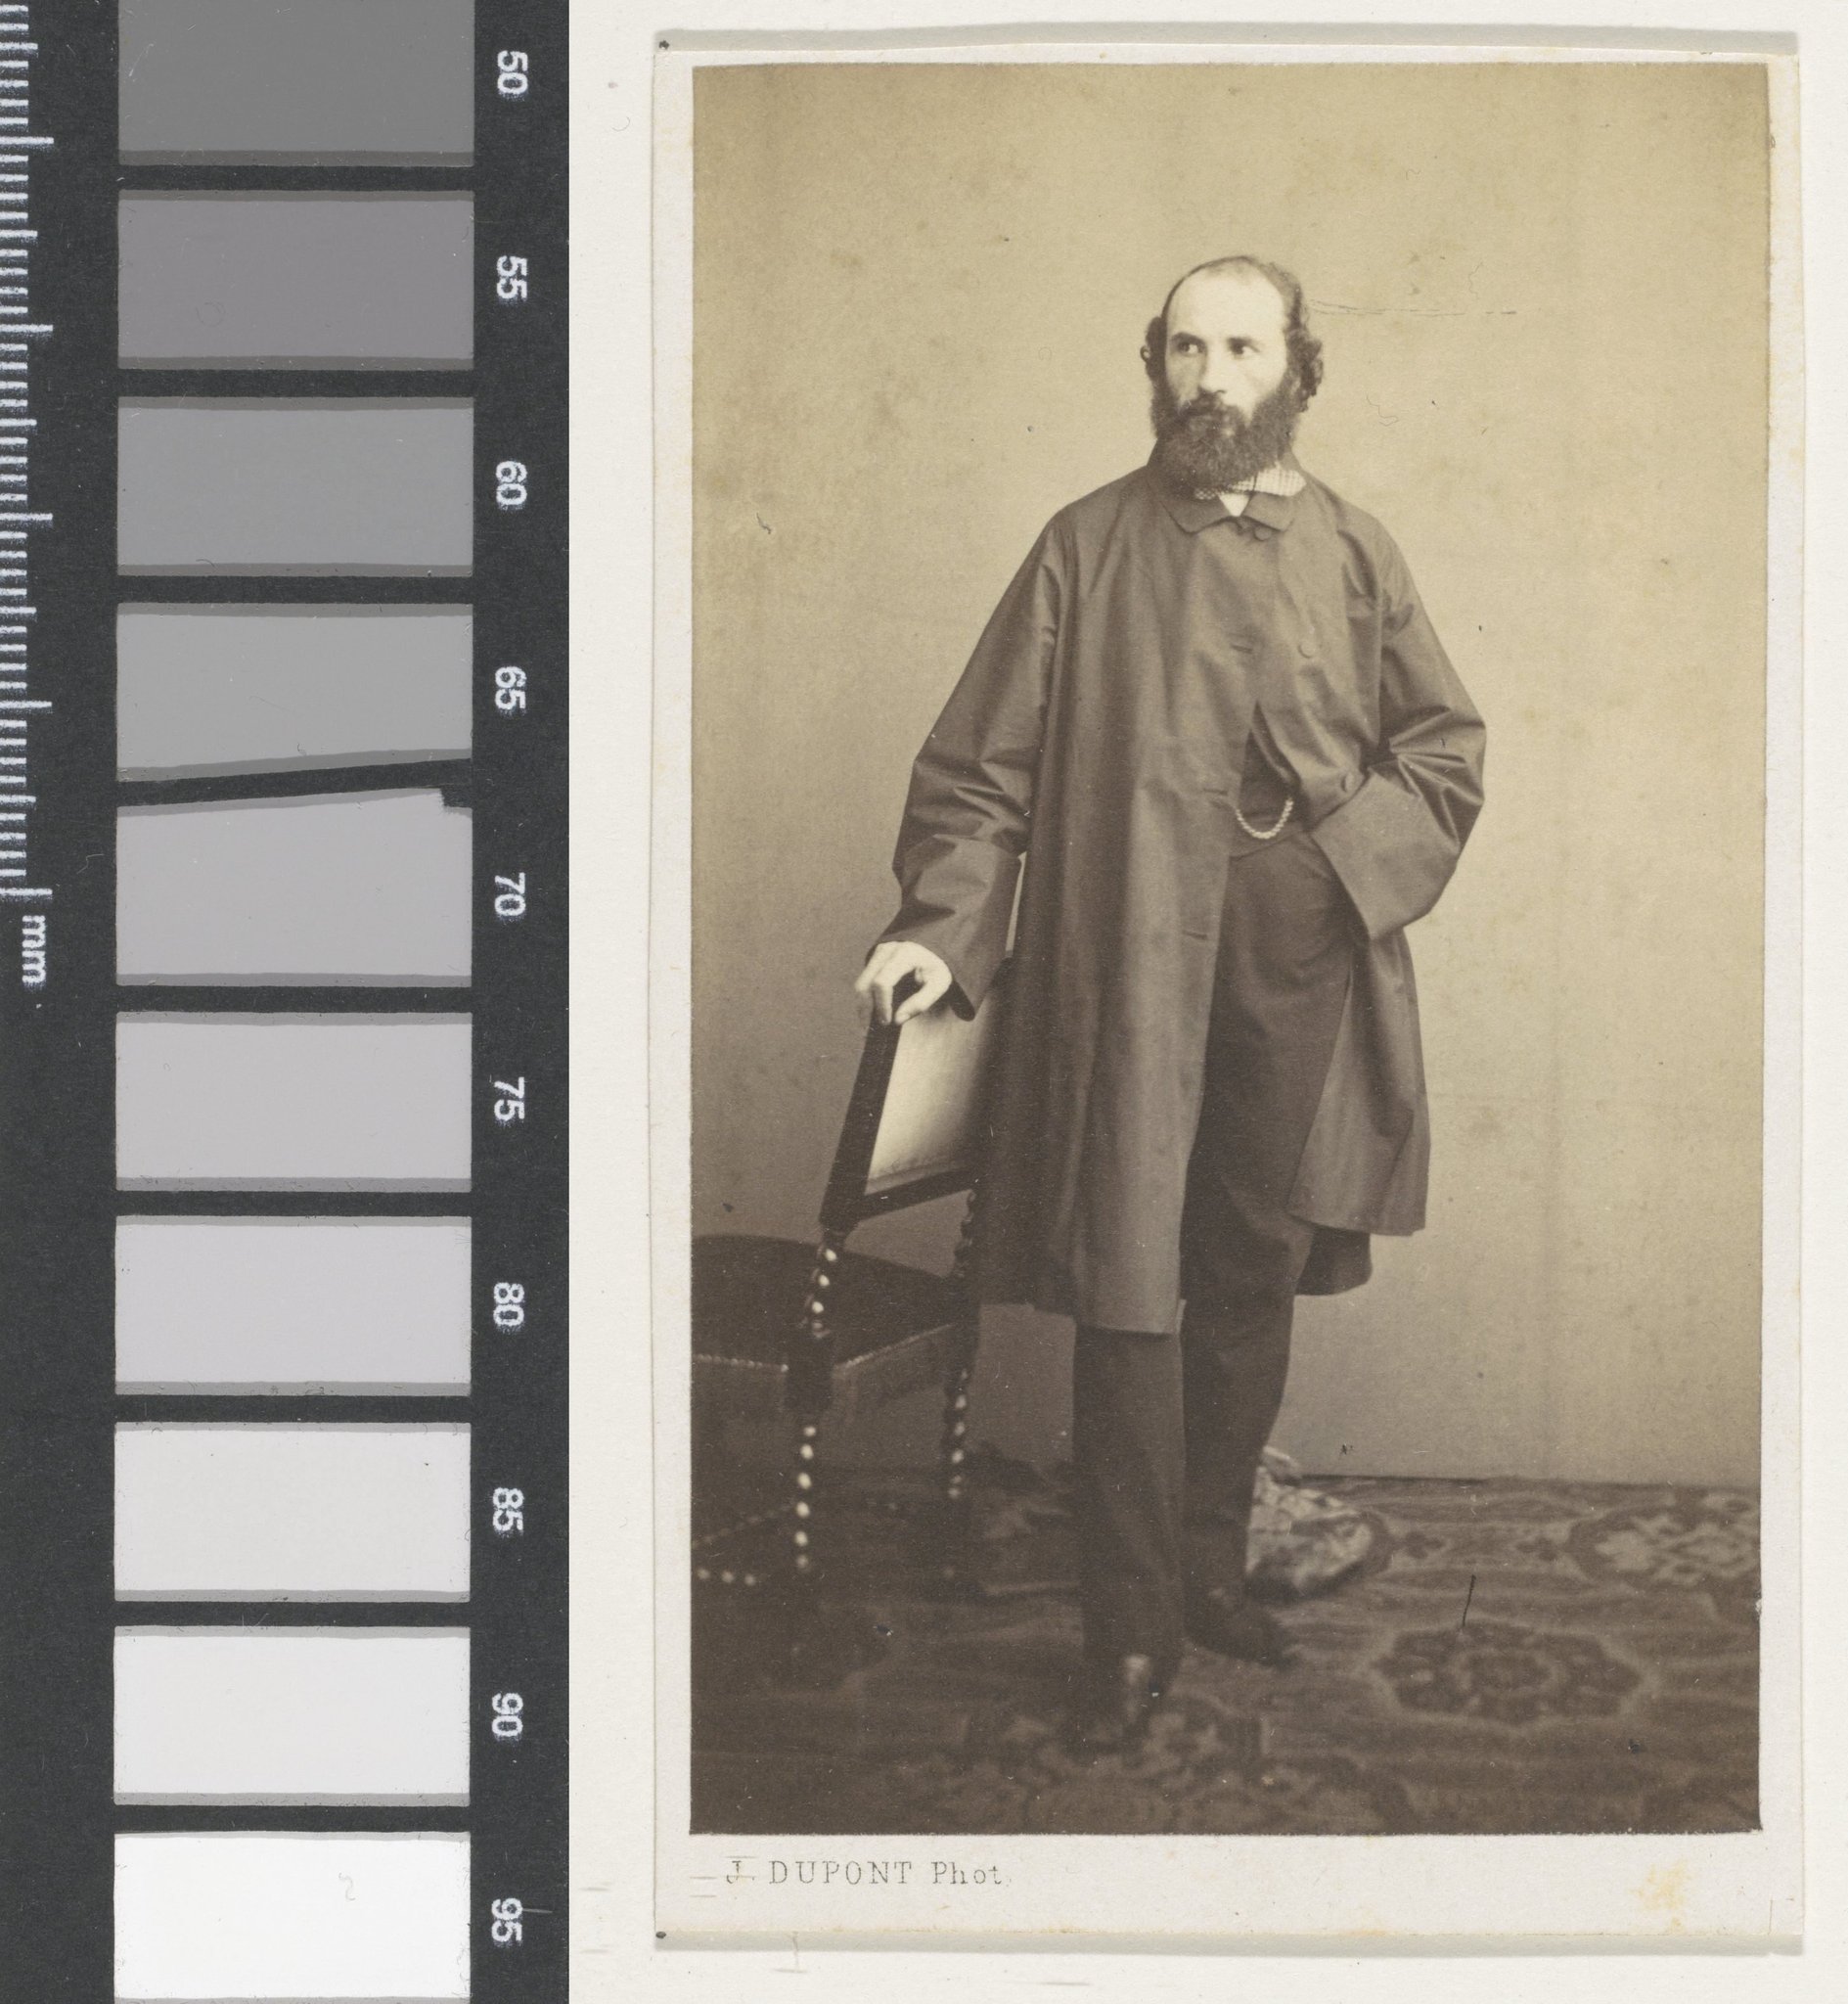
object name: carte de visite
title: Portret van de beeldhouwer Jacques De Braekeleer, ten voeten uit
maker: joseph dupont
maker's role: fotograaf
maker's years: 1818-1901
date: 1861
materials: cardboard, paper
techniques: albumen print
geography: antwerp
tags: antwerp, sculptor, jacques de braekeleer, portrait, self-portrait of sculptor, historical persons, portrait, self-portrait of artist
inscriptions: inscription: ‘ETABLISSEMENT PHOTOGRAPHIQUE/ de/ J. DUPONT/ Place de Meir 32/ ANVERS/ Maison fondée en 1853’